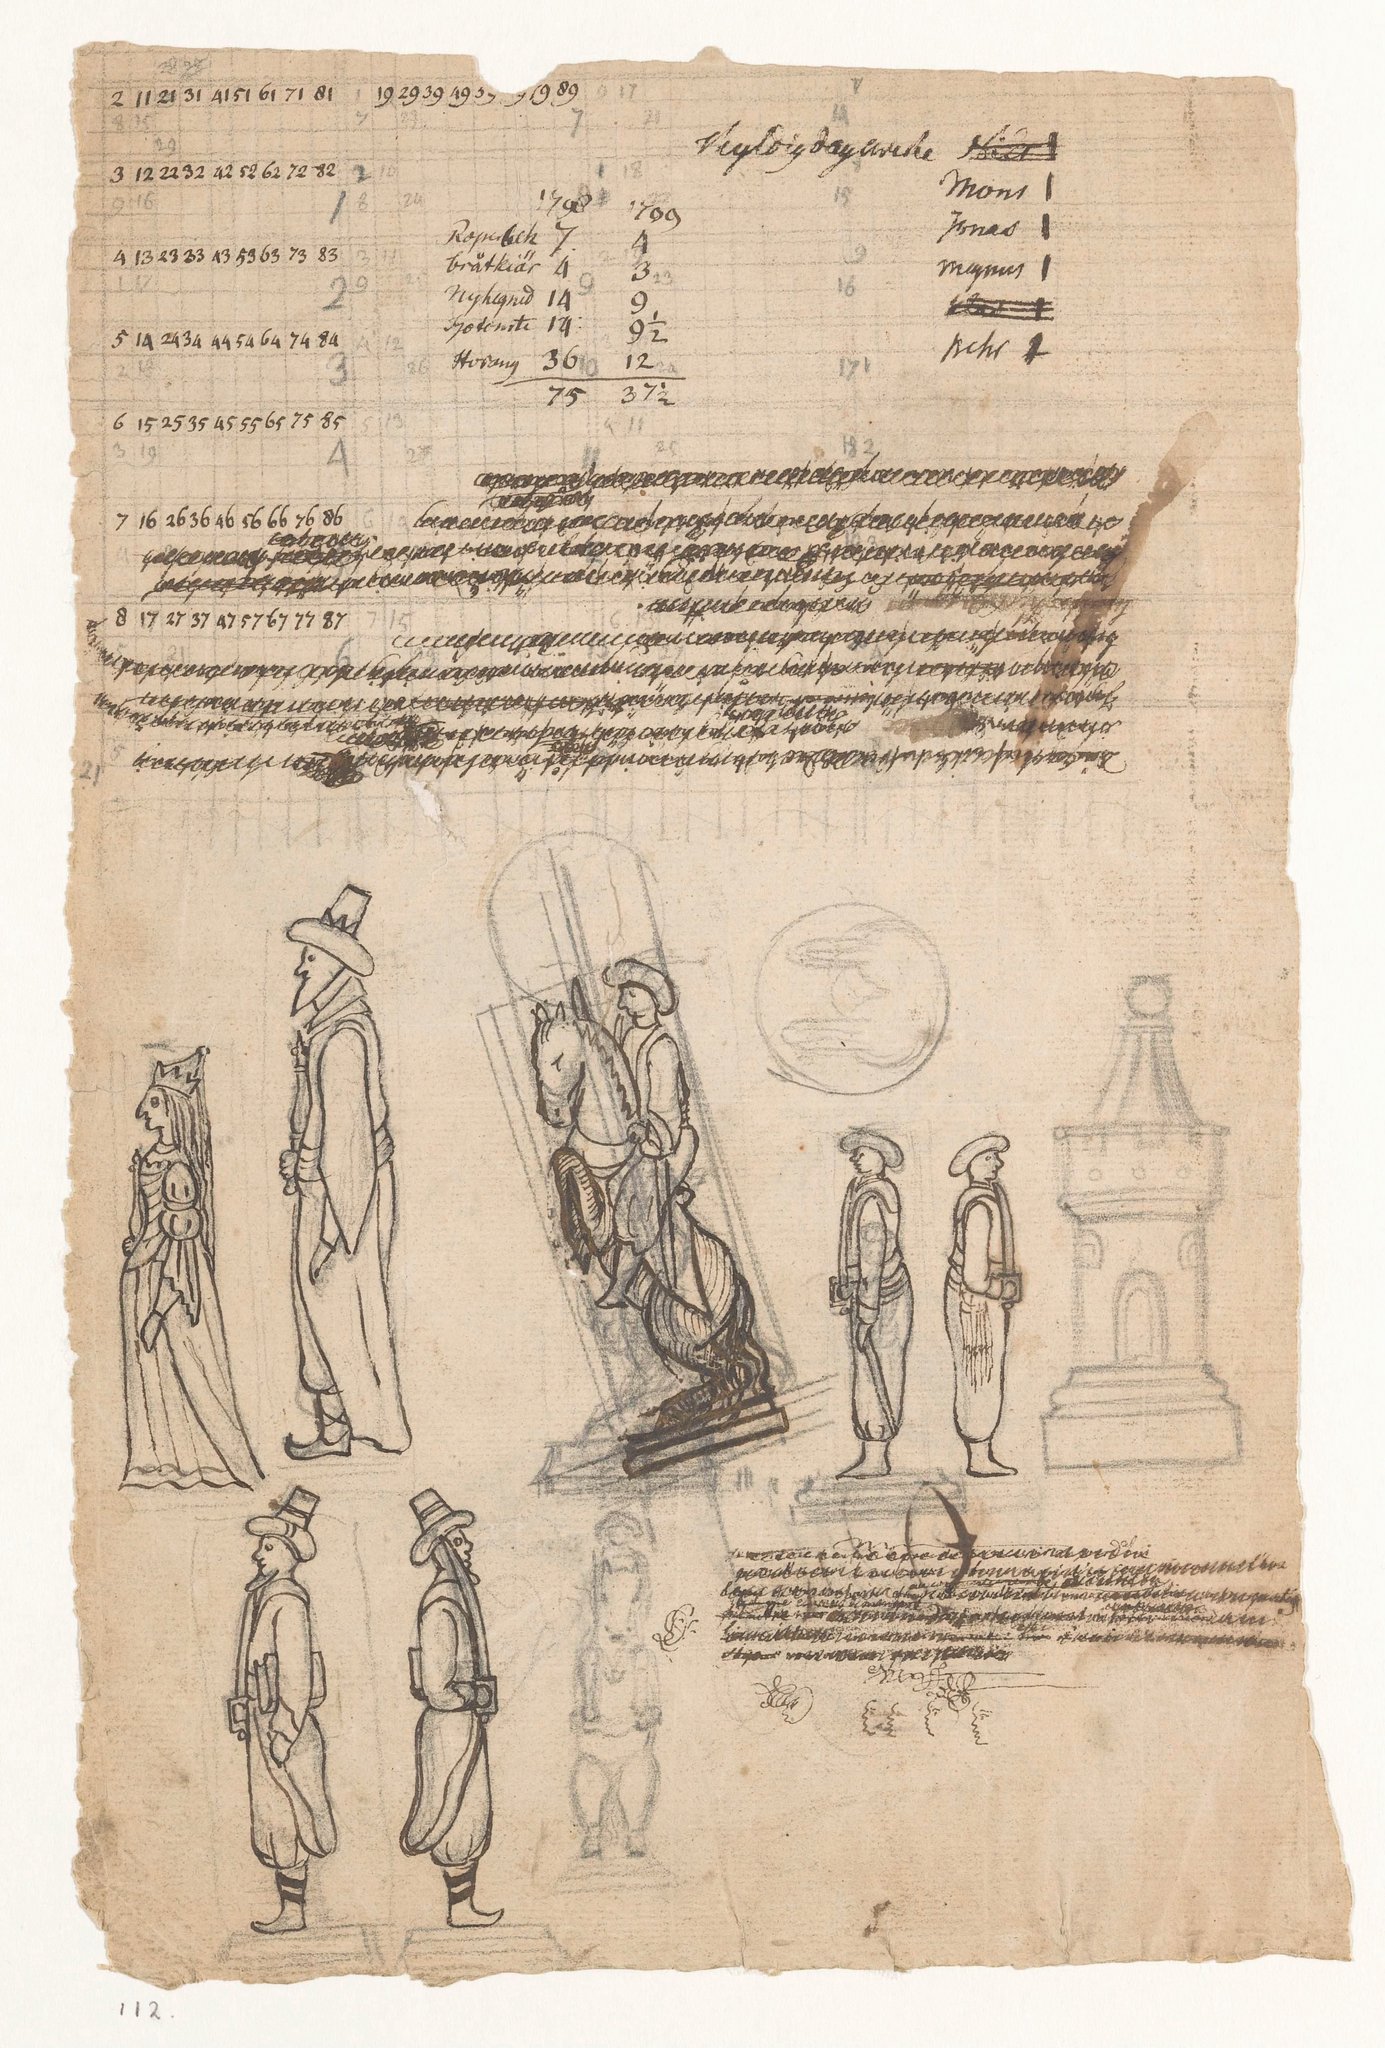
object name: drawing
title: Standbeelden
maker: jan brandes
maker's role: draughtsman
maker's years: 1743-1808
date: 1787-1808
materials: ink, paper, pencil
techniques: pen, writing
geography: skälsebo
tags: piece of sculpture, reproduction of a piece of sculpture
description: Schetsblad met studies voor diverse standbeelden en een toren. Ook doorgekraste aantekeningen en enkele berekeningen. Op de achterkant verschillende wapenschilden en een schets van het landgoed of de weg naar het landgoed Skalsebö.